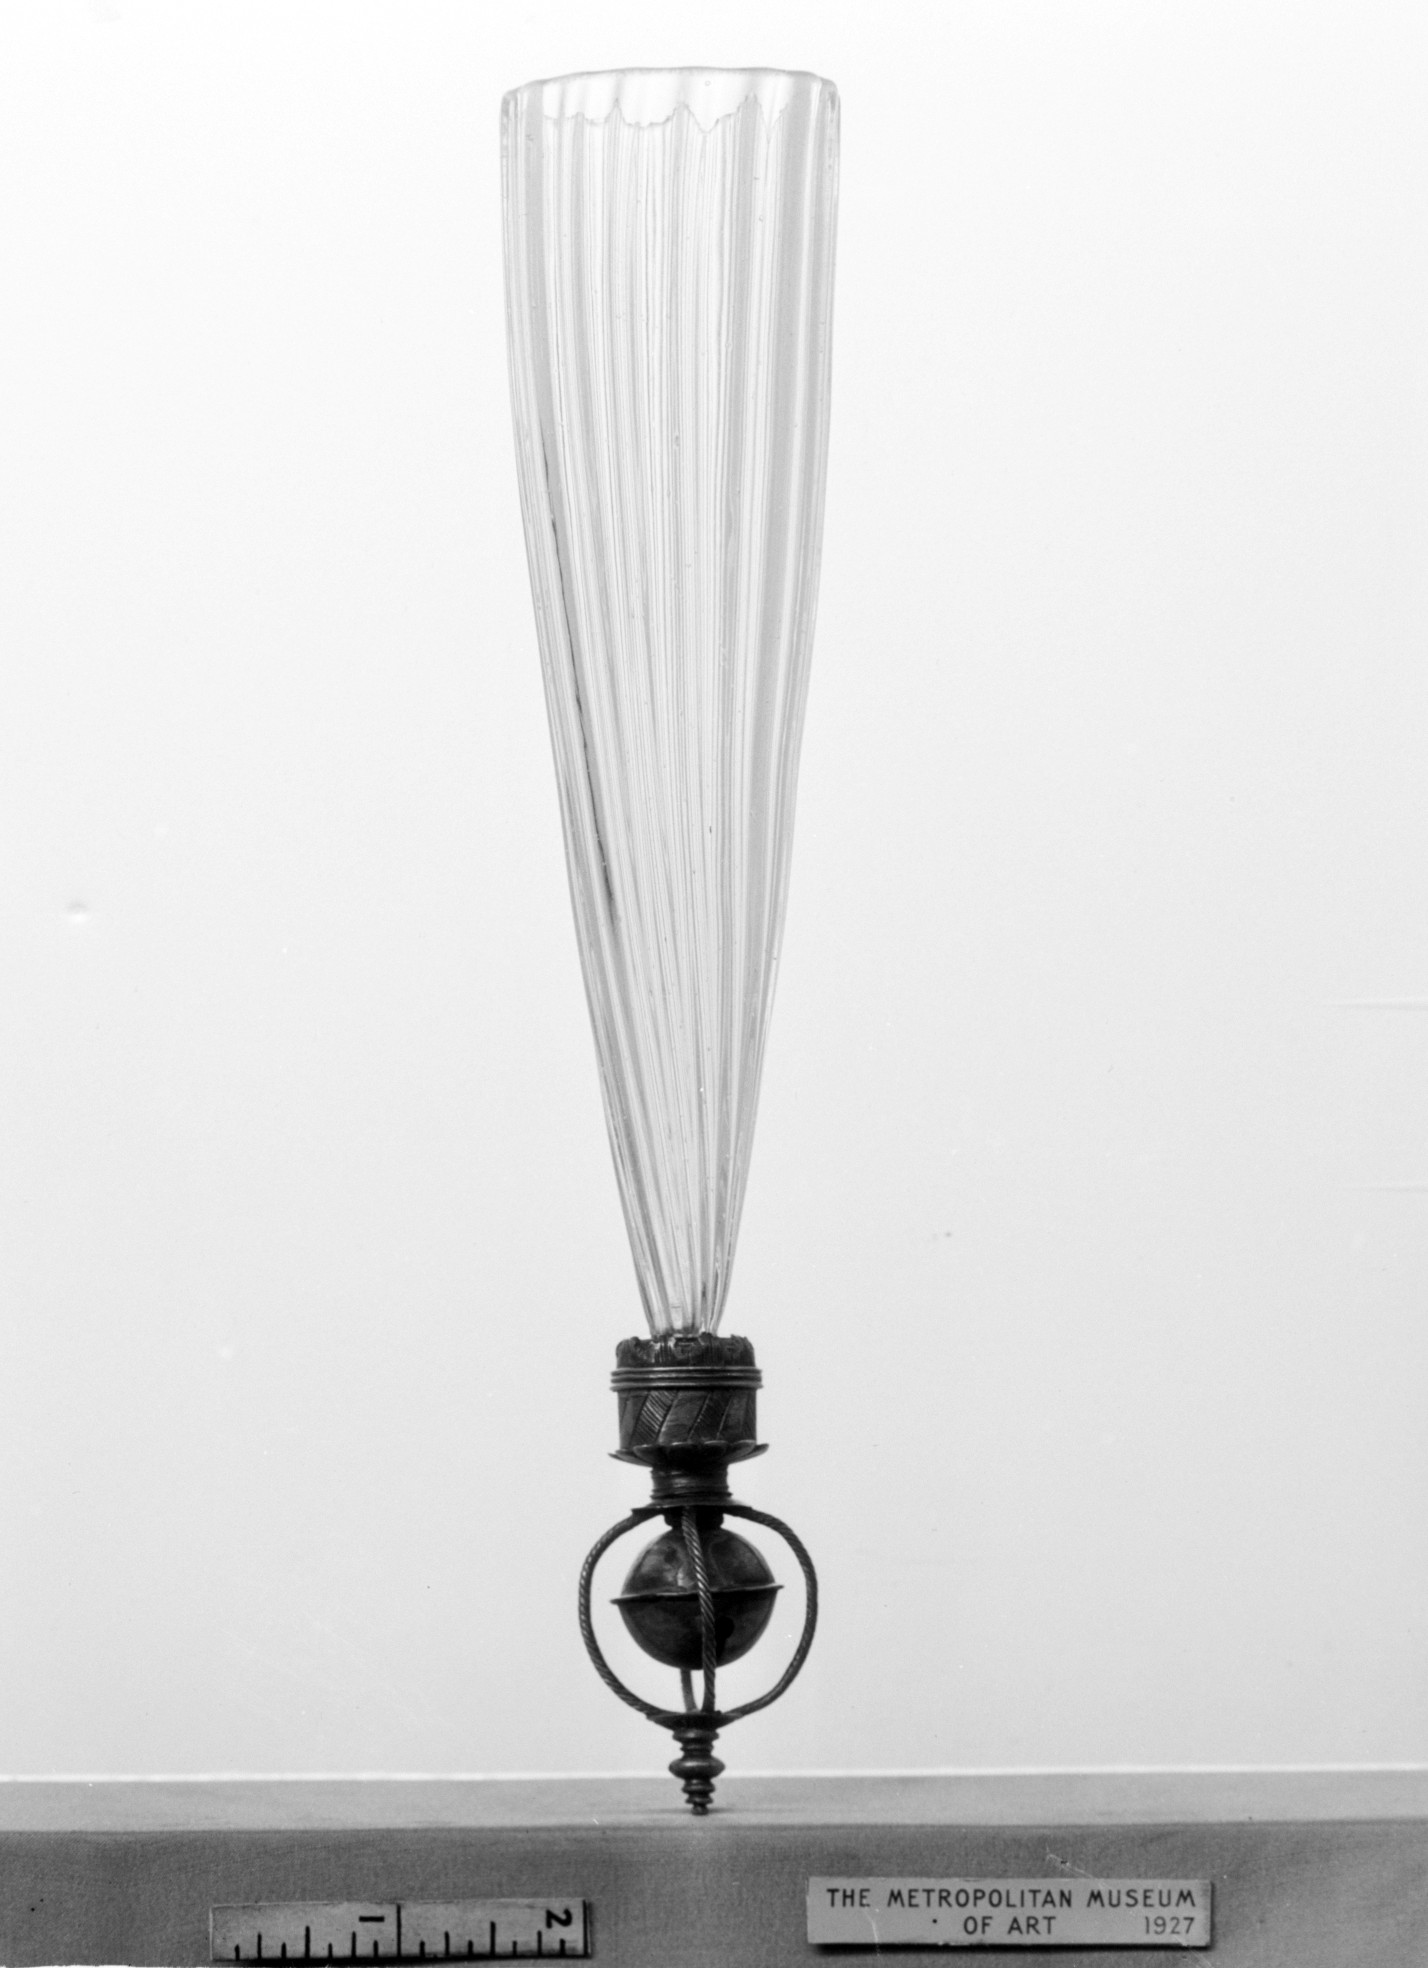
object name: wineglass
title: Wineglass (Sturzbecher)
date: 1601-1700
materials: glass, silver